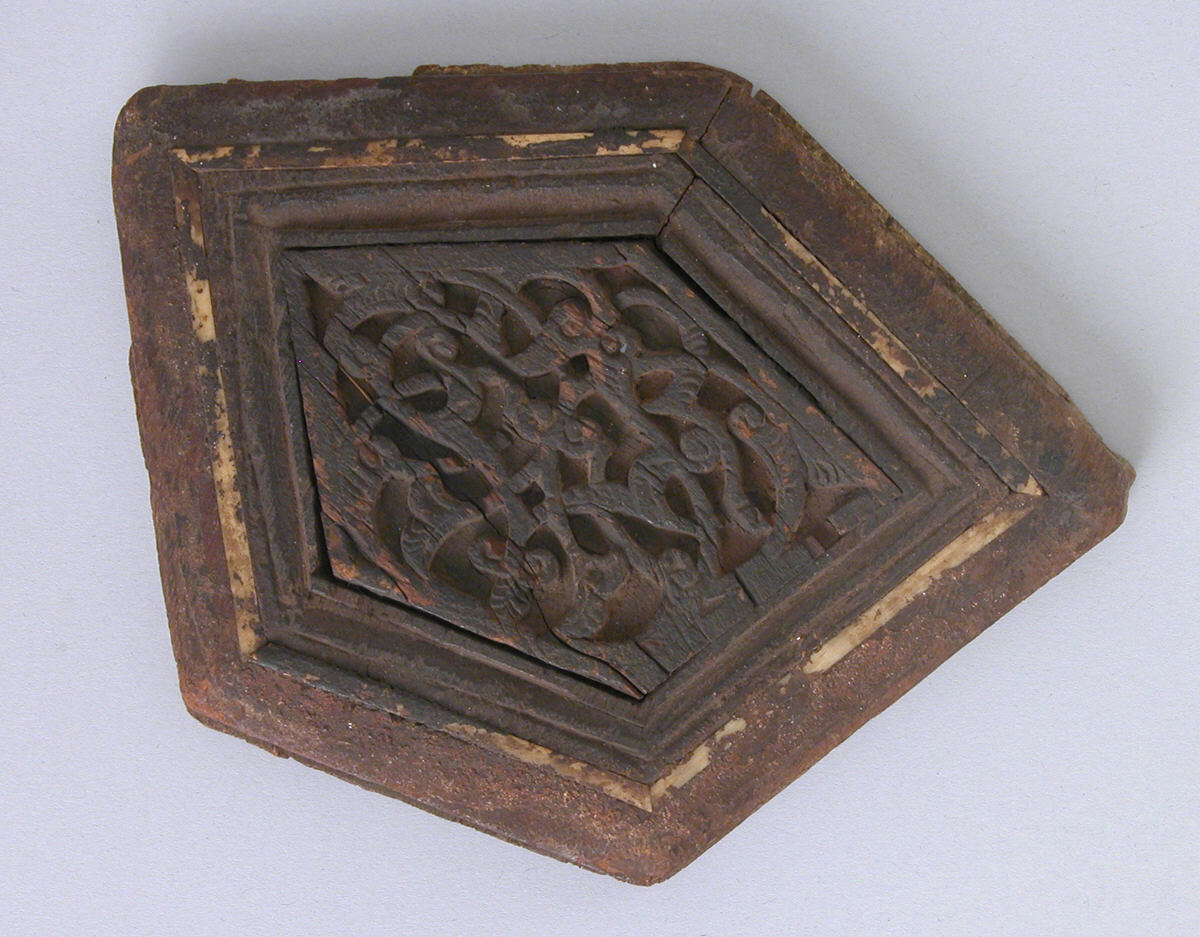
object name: panel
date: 1301-1500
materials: ivory, wood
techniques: carving, inlay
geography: egypt